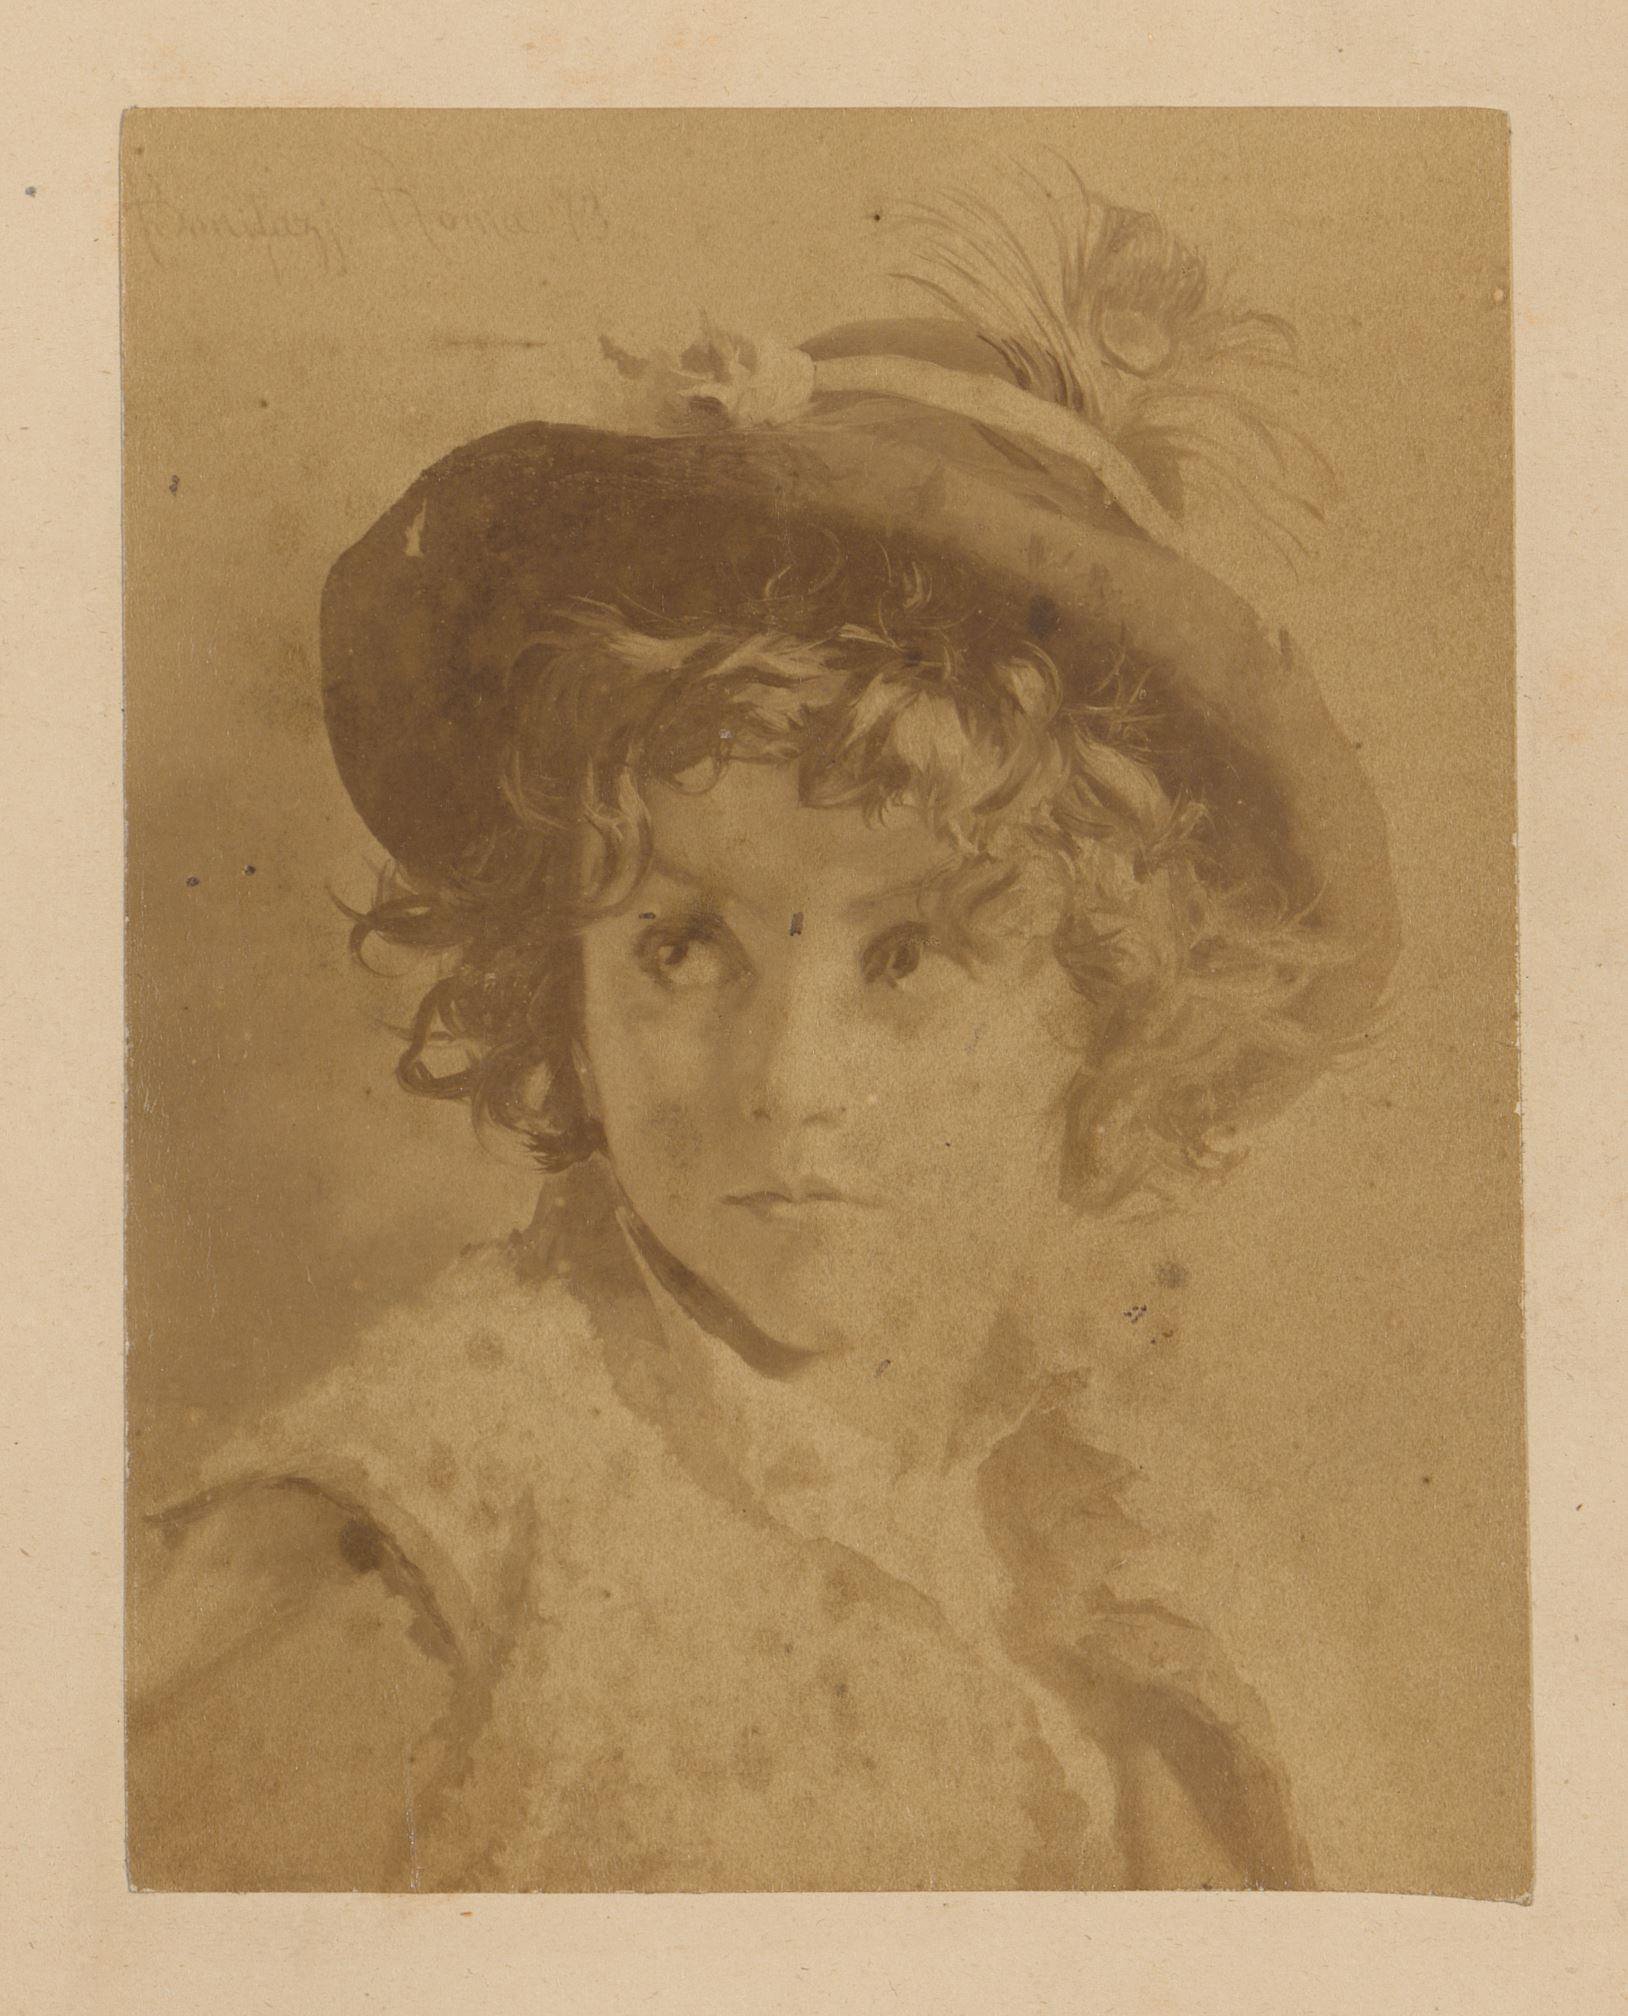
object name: album leaf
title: Fotoreproductie van een geschilderd portret van een Roma jongen met hoed naar Adriano Bonifazi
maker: Anonymous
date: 1875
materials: photographic support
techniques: albumen print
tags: boy (child between toddler and youth), wandering communities: romani or roma